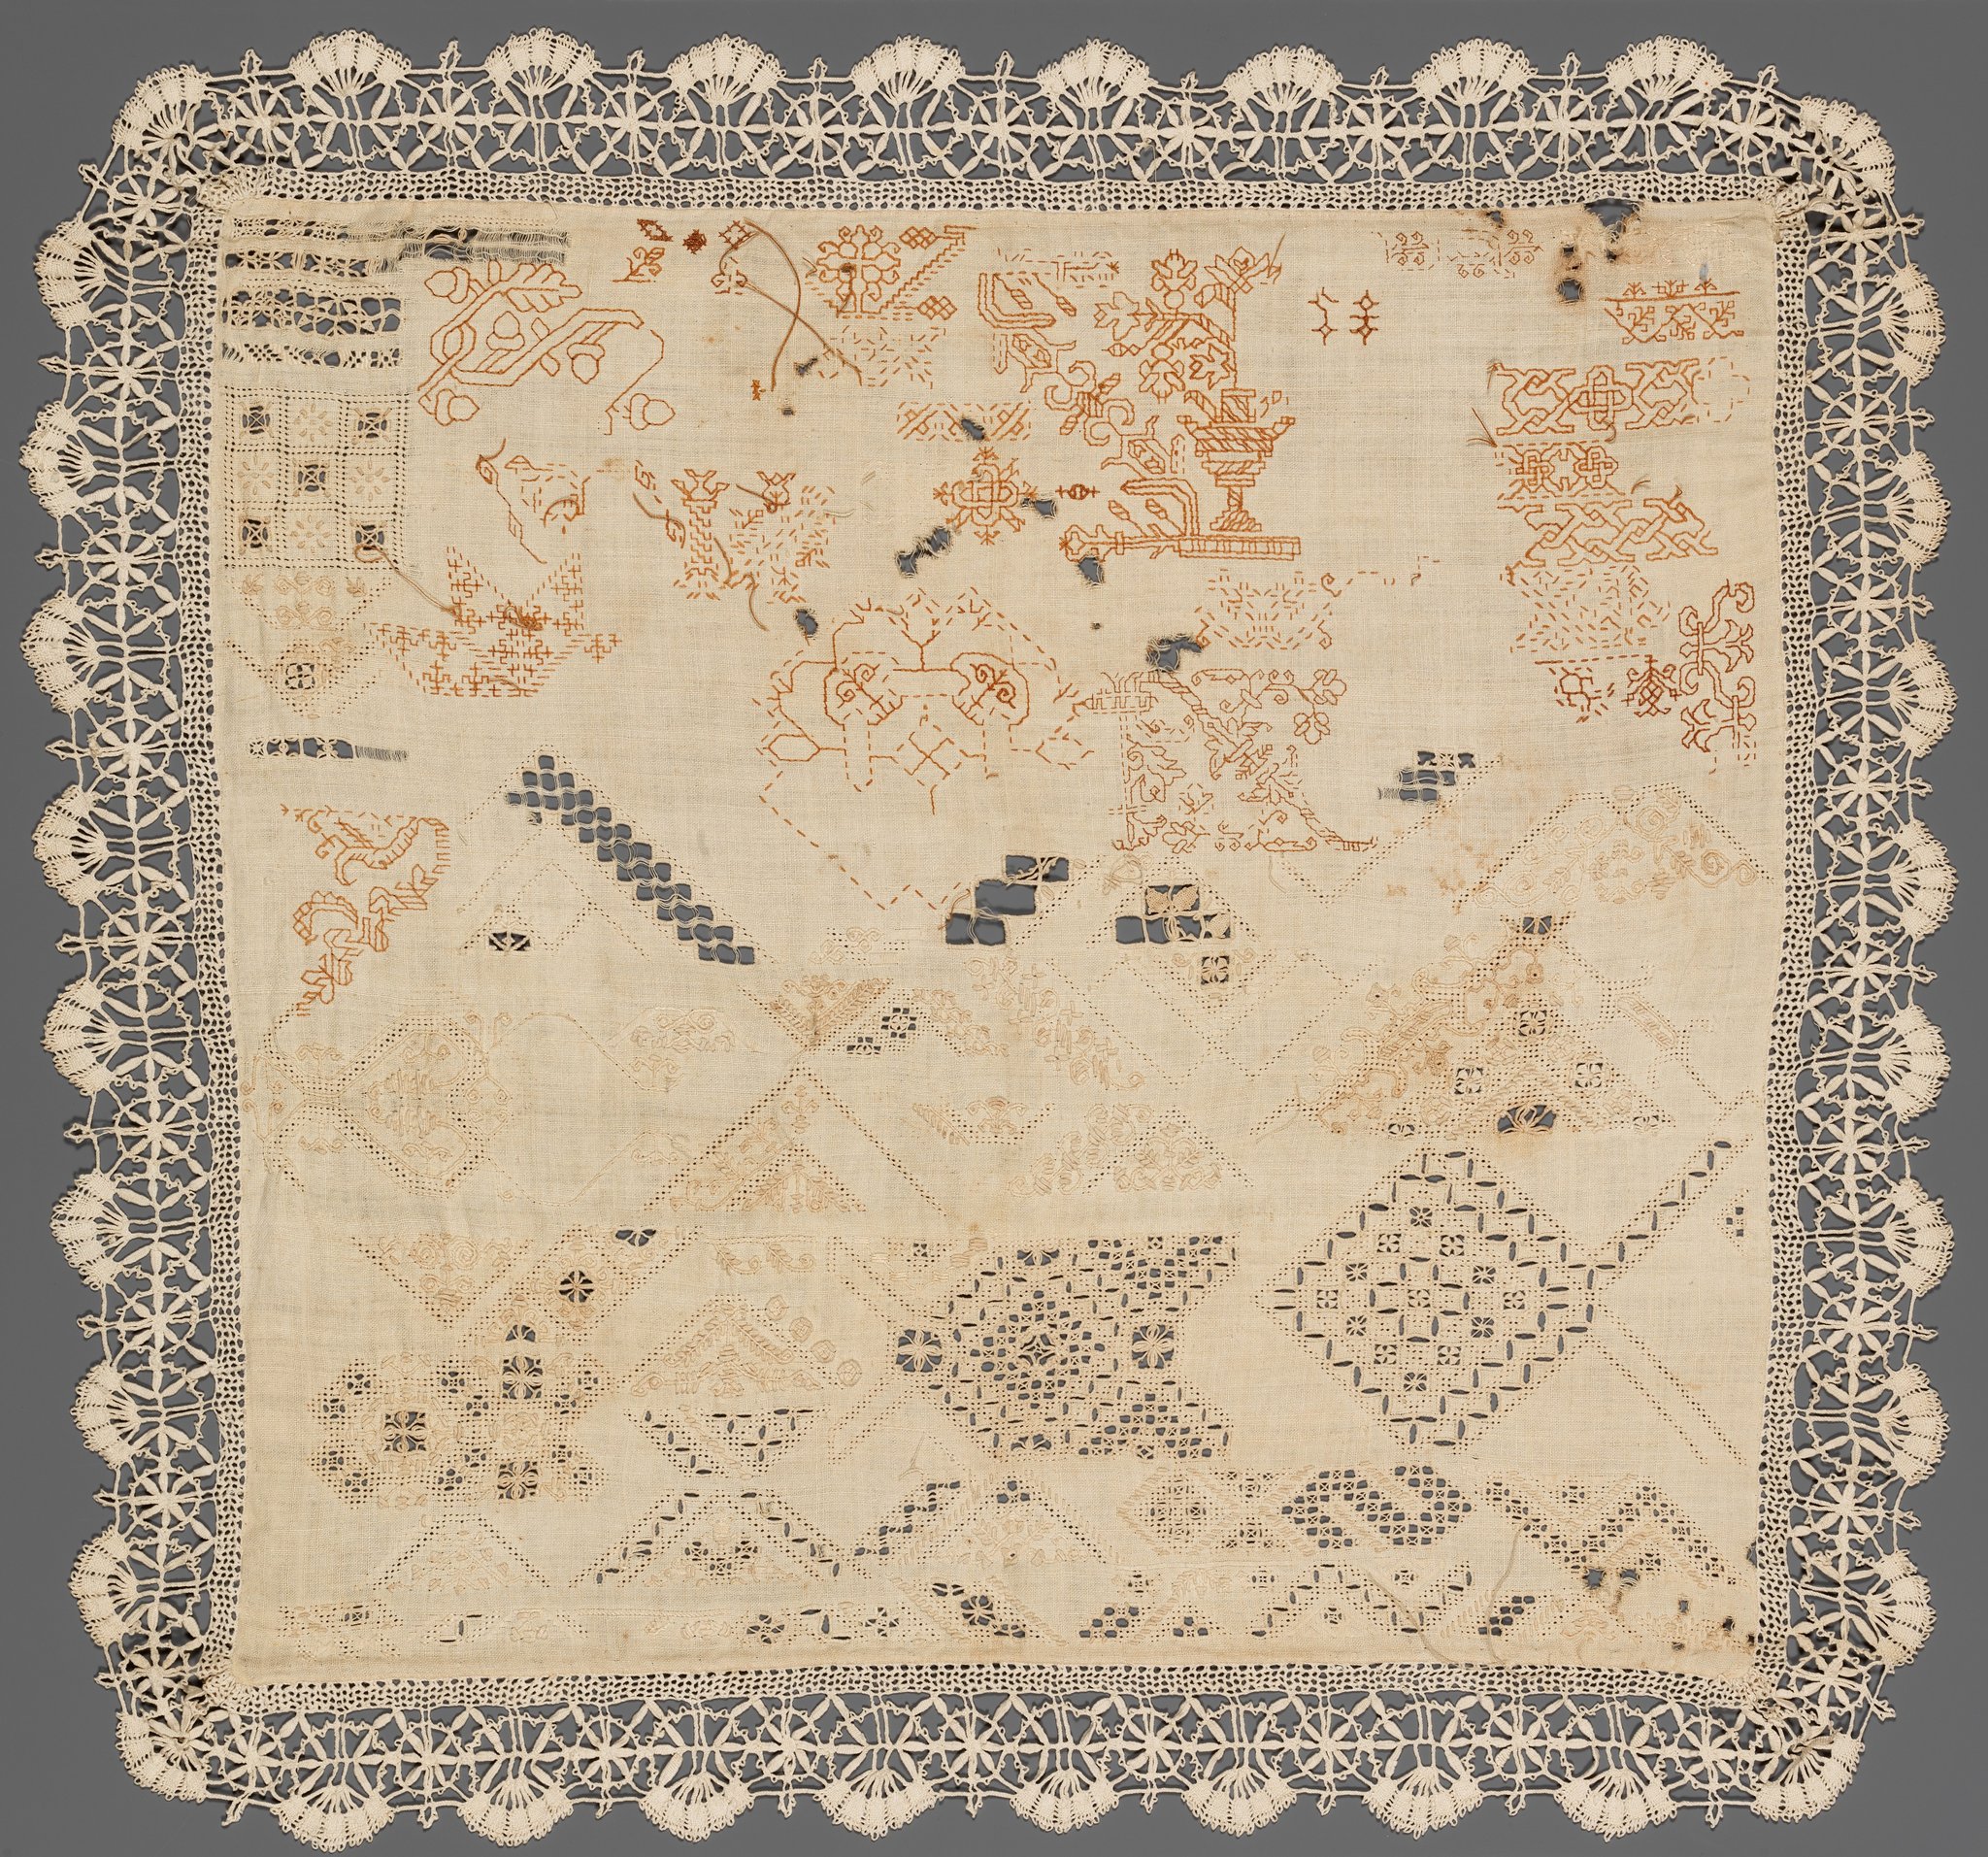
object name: sampler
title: Embroidered sampler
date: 1600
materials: linen, silk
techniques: lace